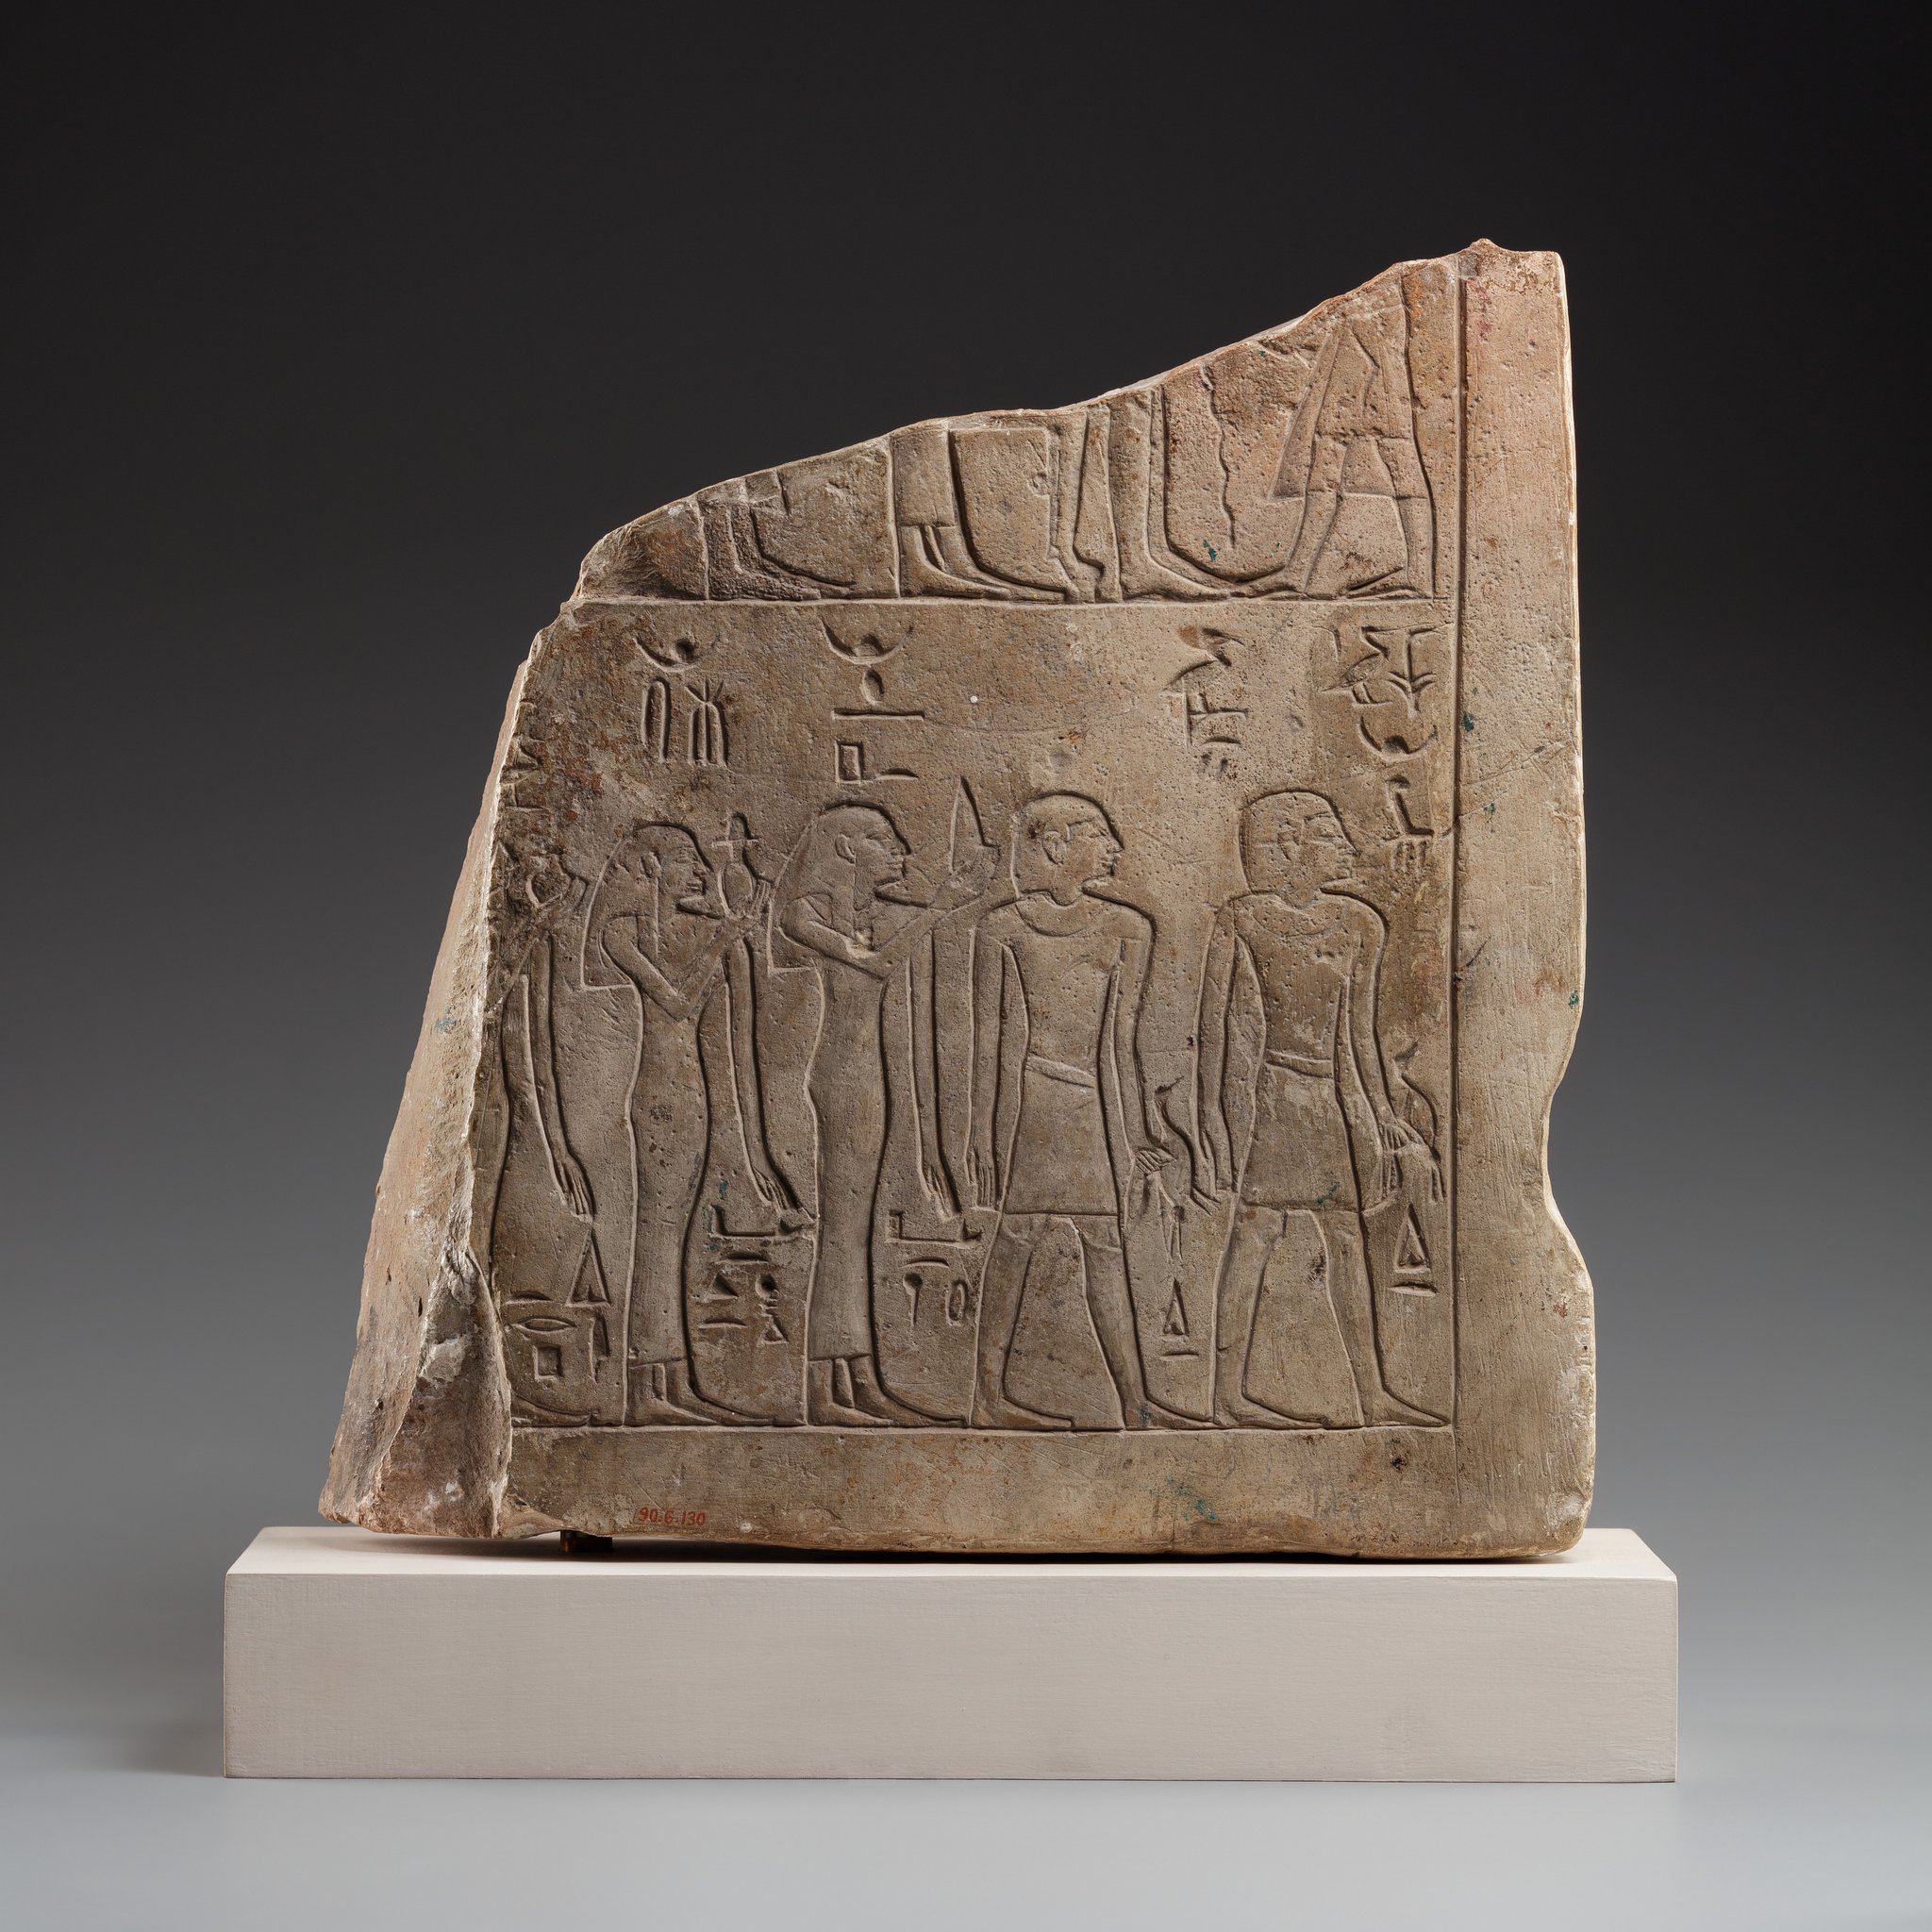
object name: stela, djehuty, ahhotep, ahmose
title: Stela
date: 1550-1525 BCE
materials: limestone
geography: egypt